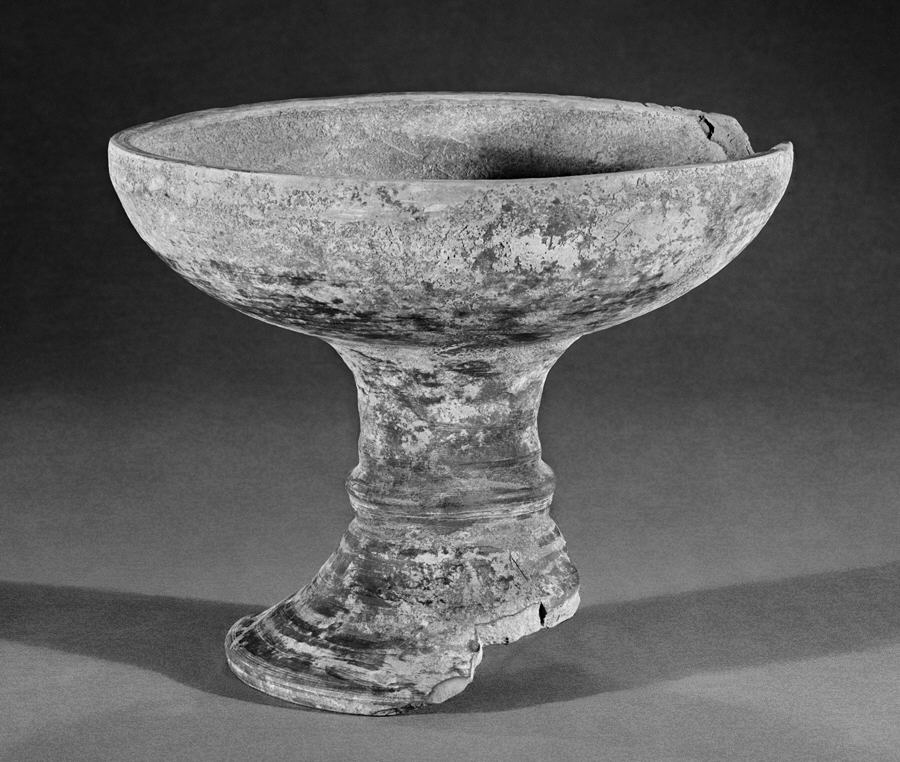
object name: bowl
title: Stemmed Bowl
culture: chinese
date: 1046-256 BCE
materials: earthenware